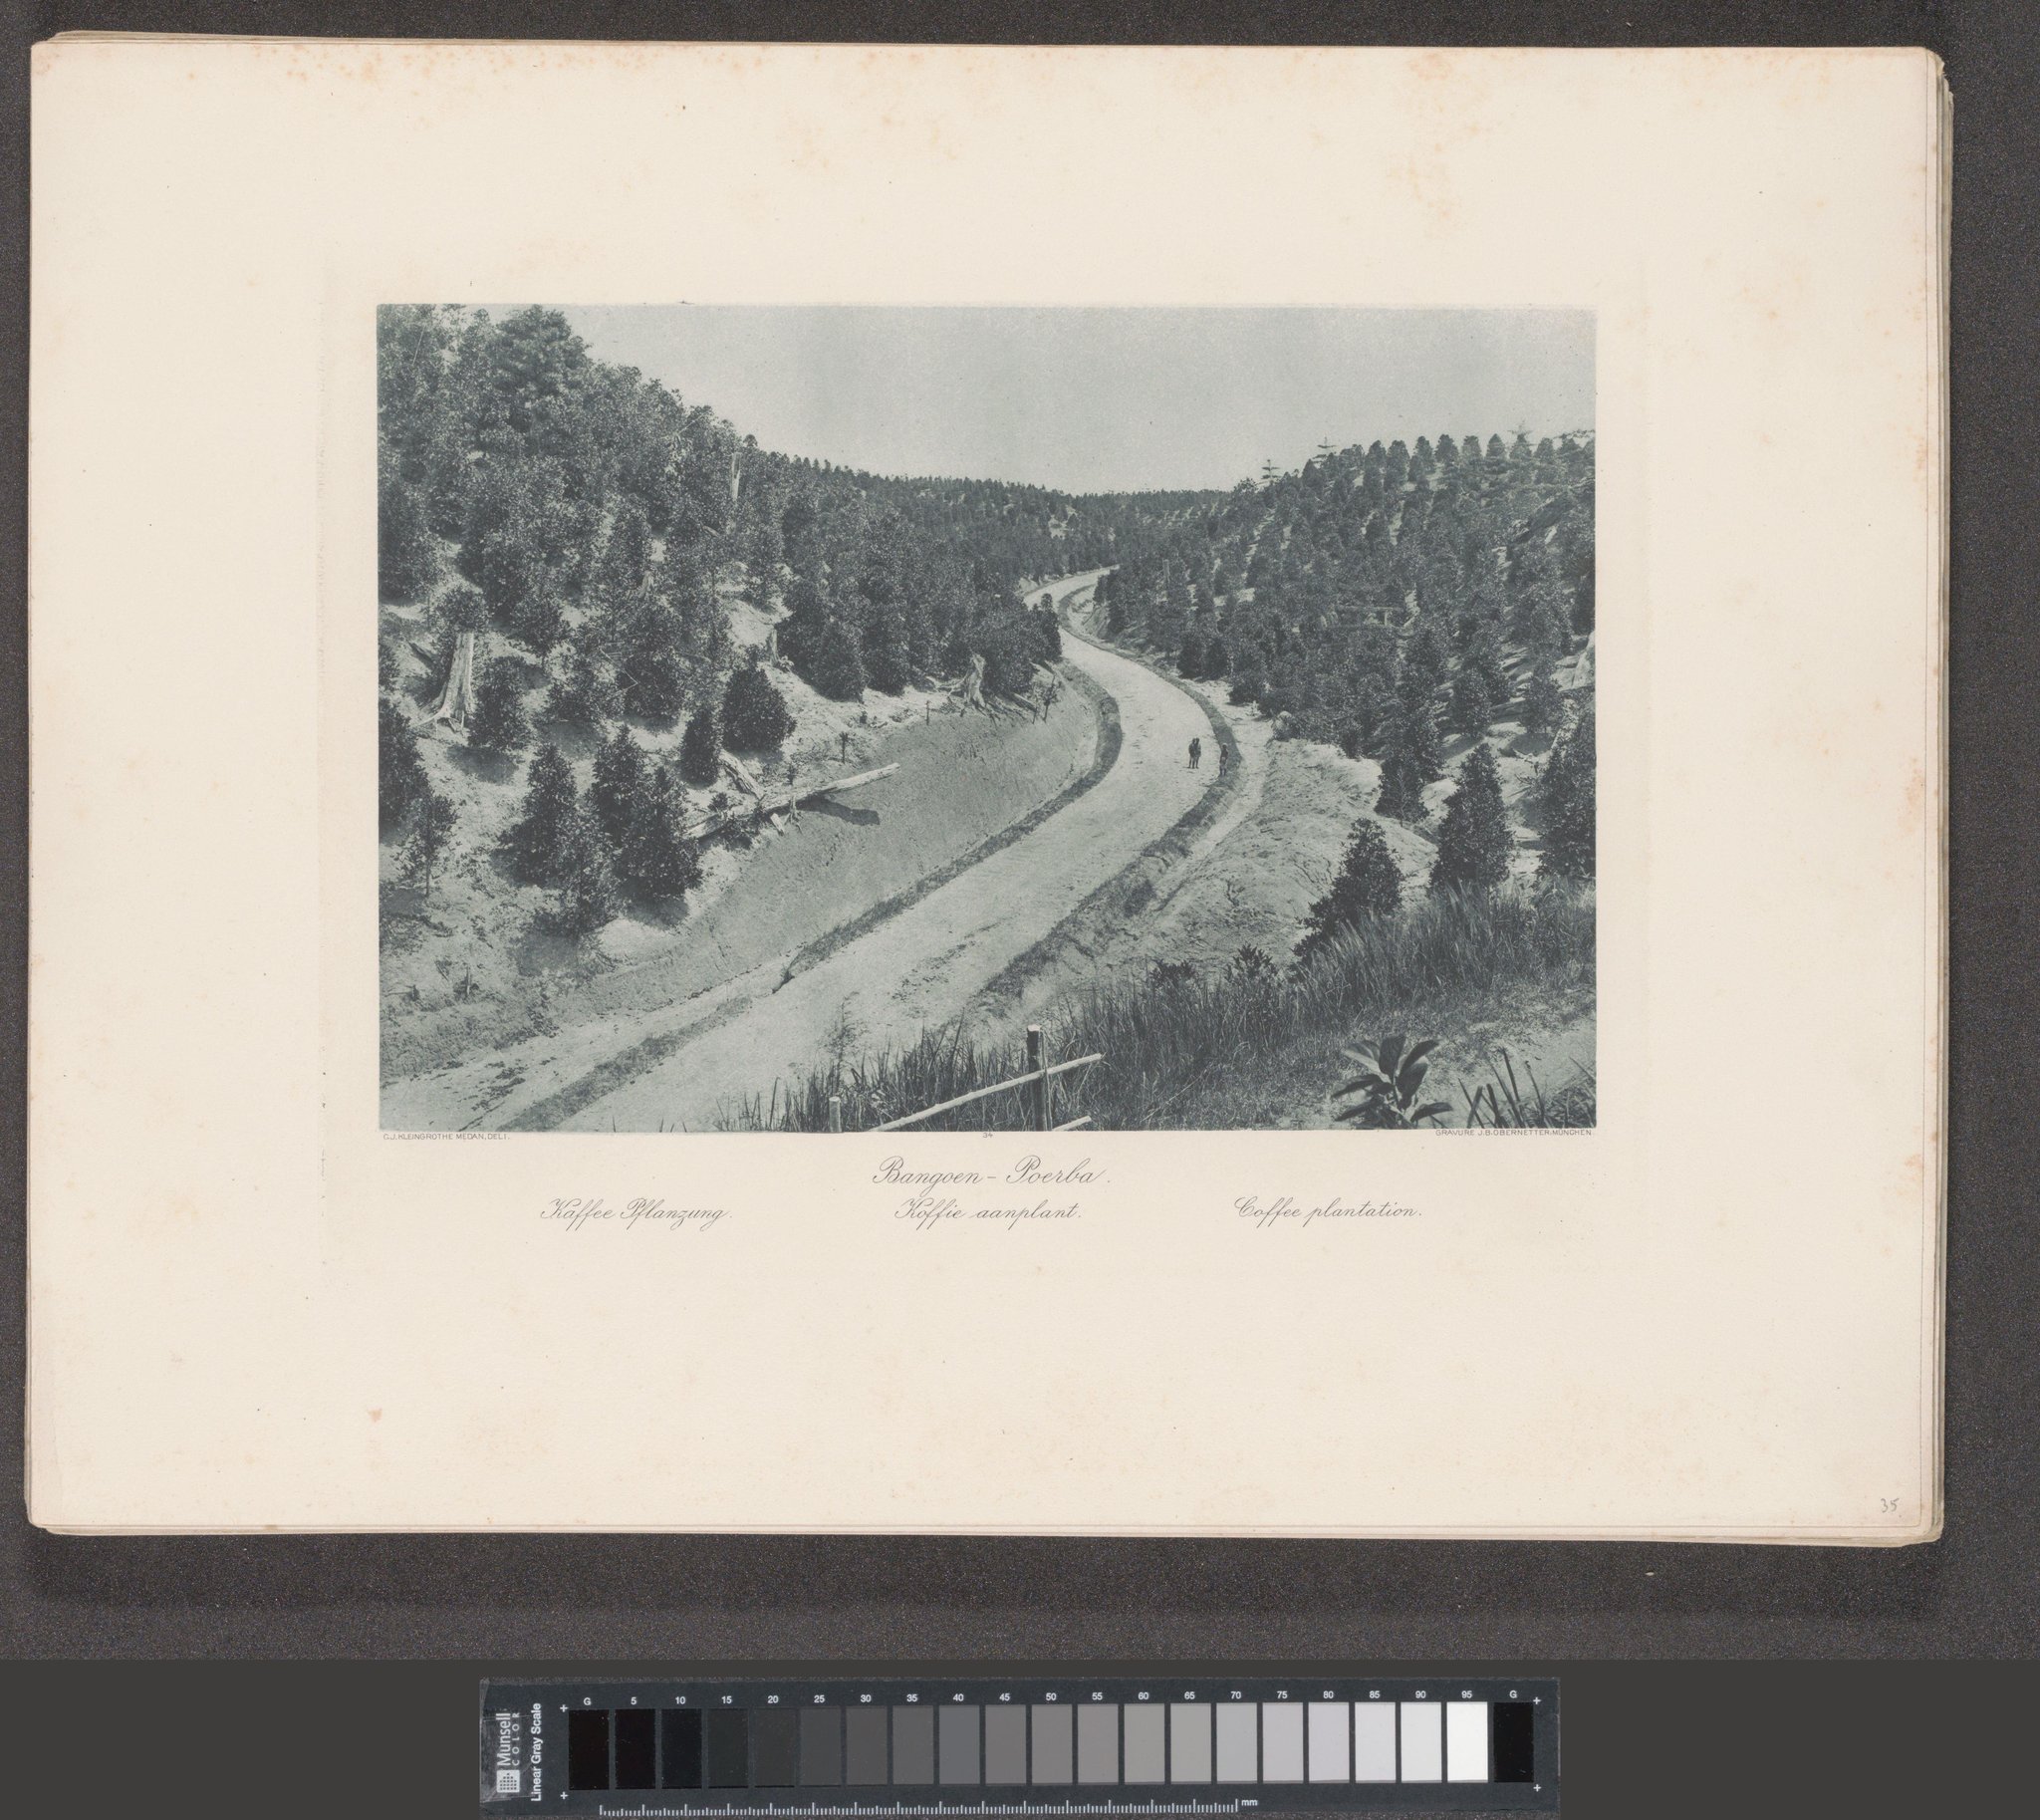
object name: photomechanical print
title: Bangoen - Poerba. Koffie aanplant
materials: paper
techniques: photoaquatint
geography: sumatra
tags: plantation, coffee, road, path, sumatra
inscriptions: number: ‘34’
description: Onderdeel van Album met heliogravures van Sumatra's oostkust.